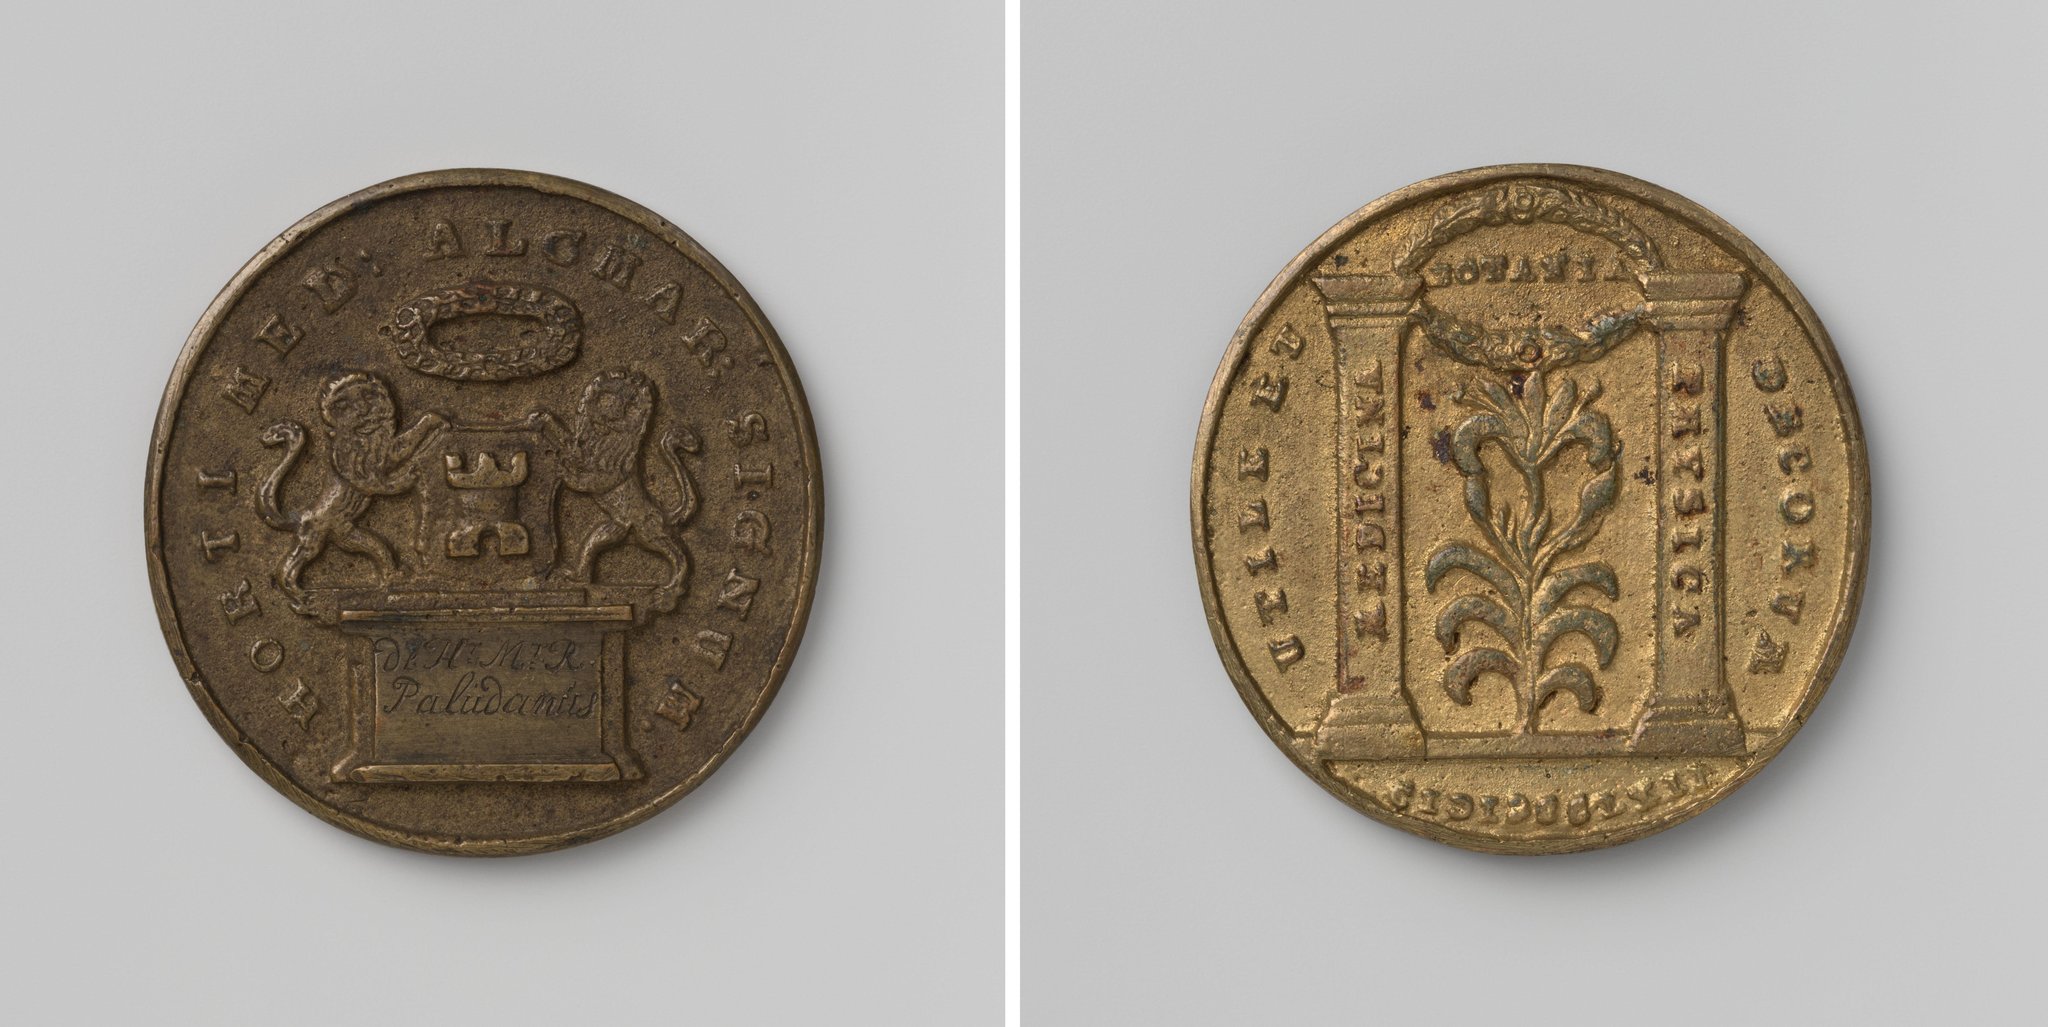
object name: toegangspenning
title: Collegium Medico-Pharmaceuticum te Alkmaar, toegangspenning voor de hortus medicus voor R. Paludanus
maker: Anonymous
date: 1762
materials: brass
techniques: casting, engraving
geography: alkmaar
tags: r. paludanus, alkmaar